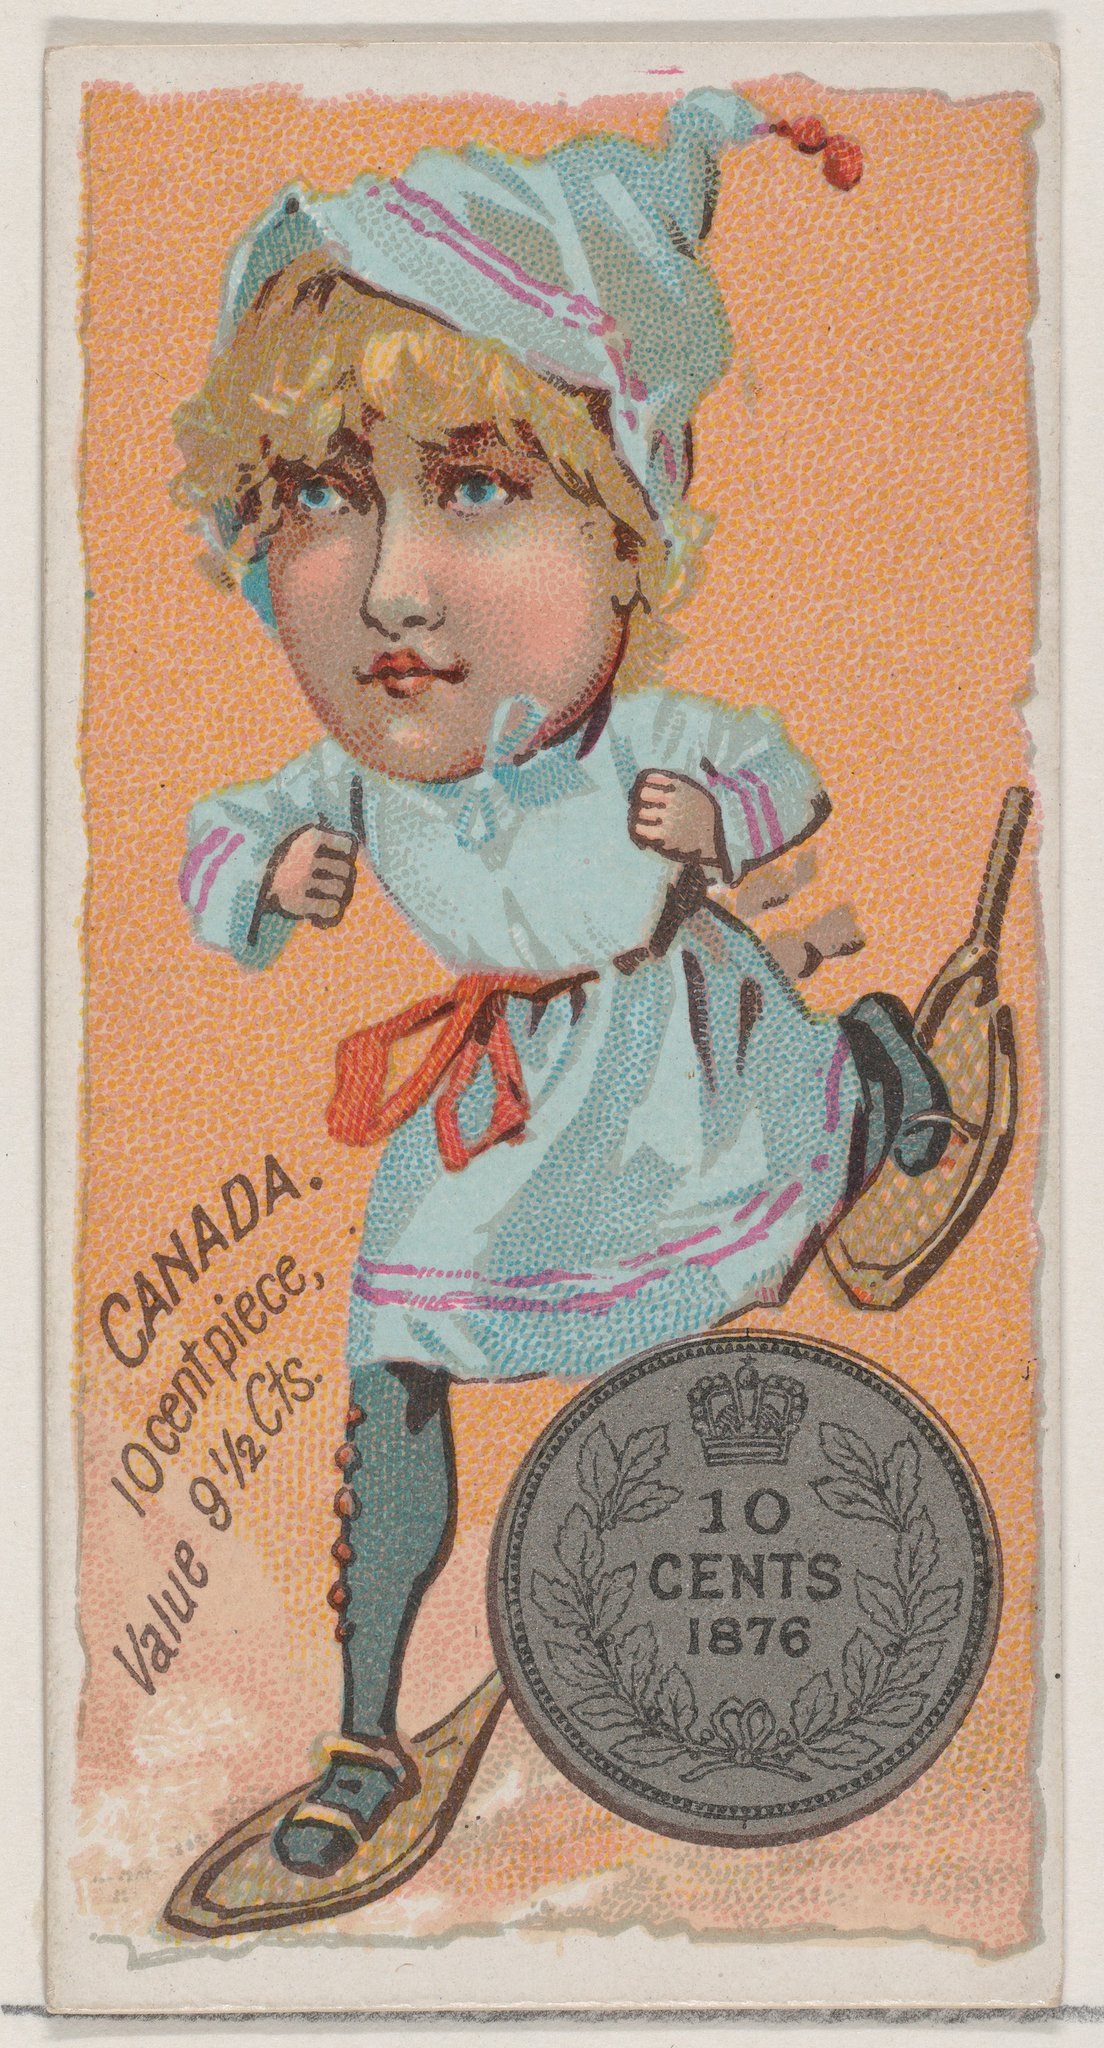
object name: print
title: Canada, 10 Cent Piece, from the series Coins of All Nations (N72, variation 2) for Duke brand cigarettes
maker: w. duke, sons & co.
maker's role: publisher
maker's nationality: american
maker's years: 1870-1920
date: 1889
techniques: color lithograph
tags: coins